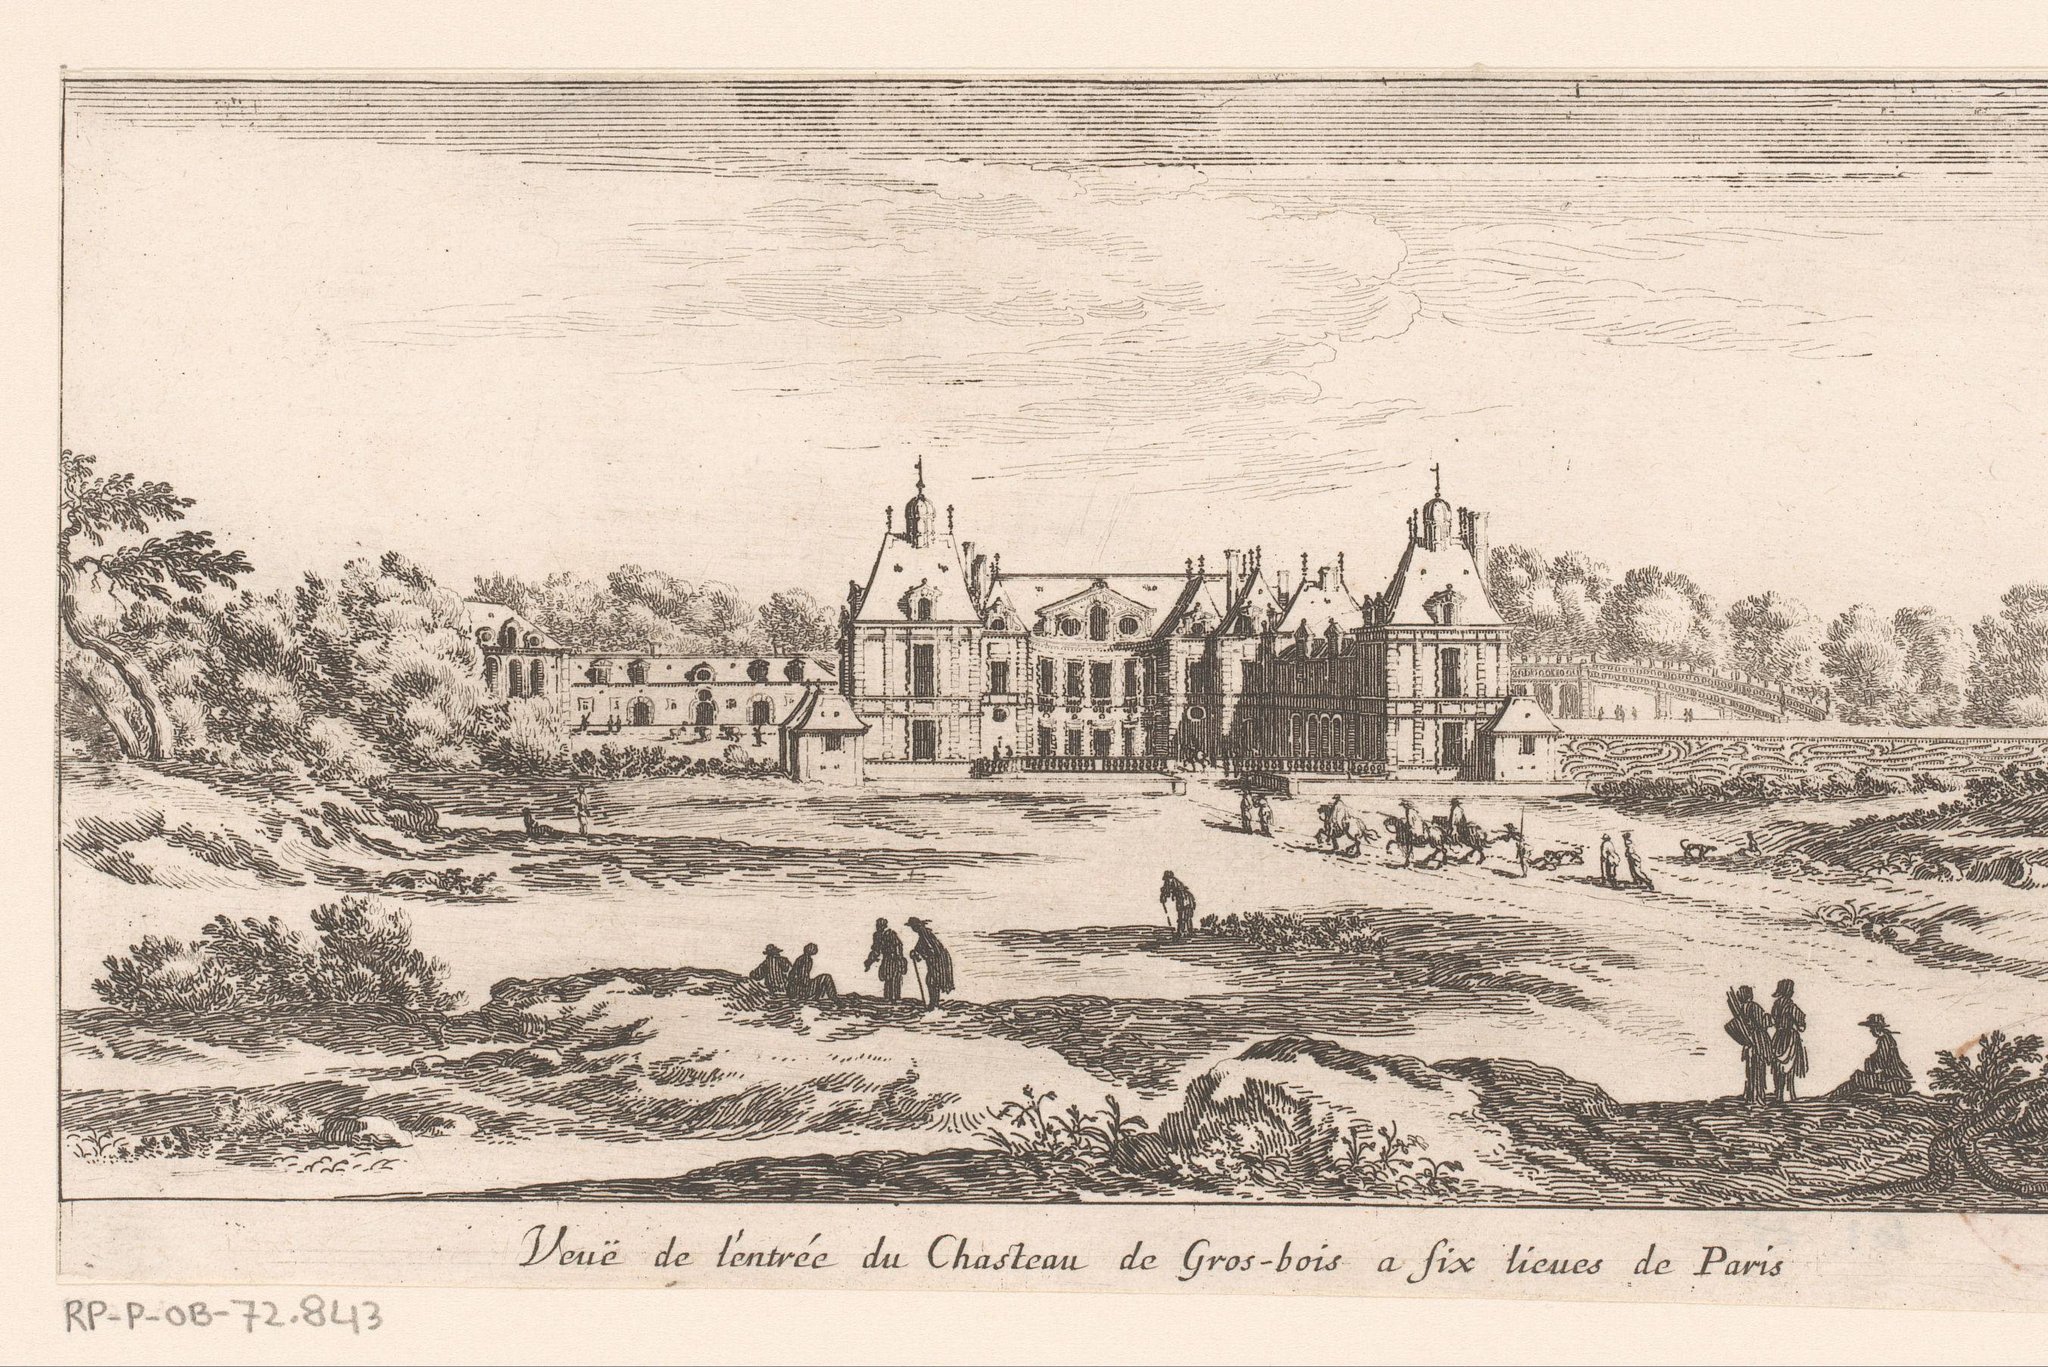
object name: print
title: Veue de l'entrée du Chasteau de Gros-Bois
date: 1650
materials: paper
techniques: etching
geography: france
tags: landscape with tower or castle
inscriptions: collector's mark: Lugt 240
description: Prent maakt deel uit van een ongenummerde serie van zestien prenten.